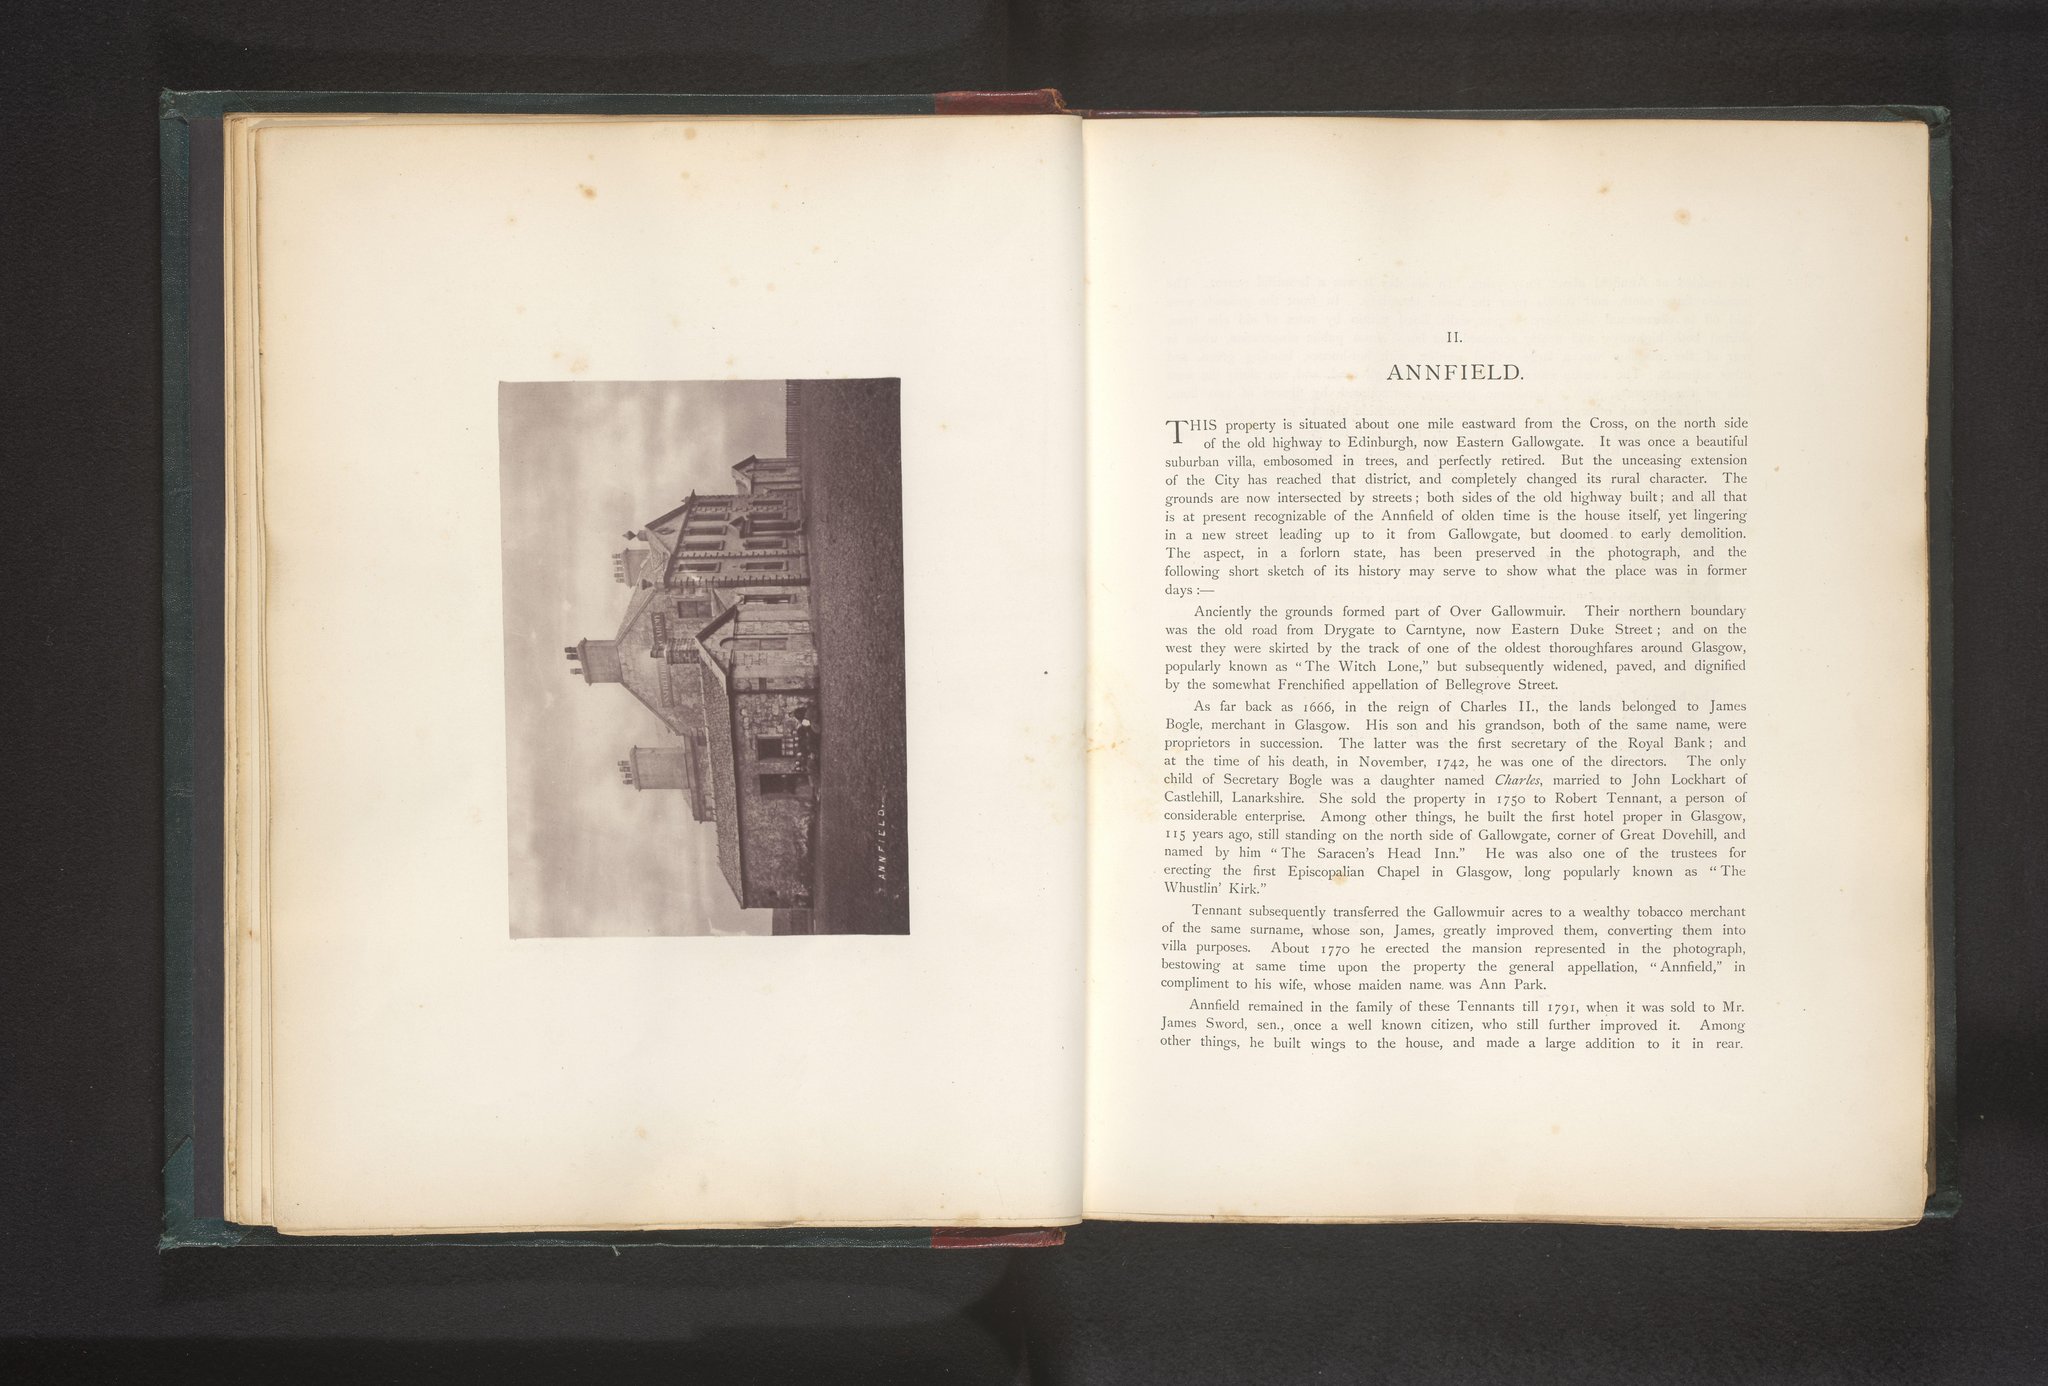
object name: page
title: Annfield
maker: thomas annan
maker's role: fotograaf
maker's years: 1829-1887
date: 1868-1878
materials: paper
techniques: carbon print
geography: glasgow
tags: rural housing, e.g. country-house, villa, cottage, façade (of house or building)